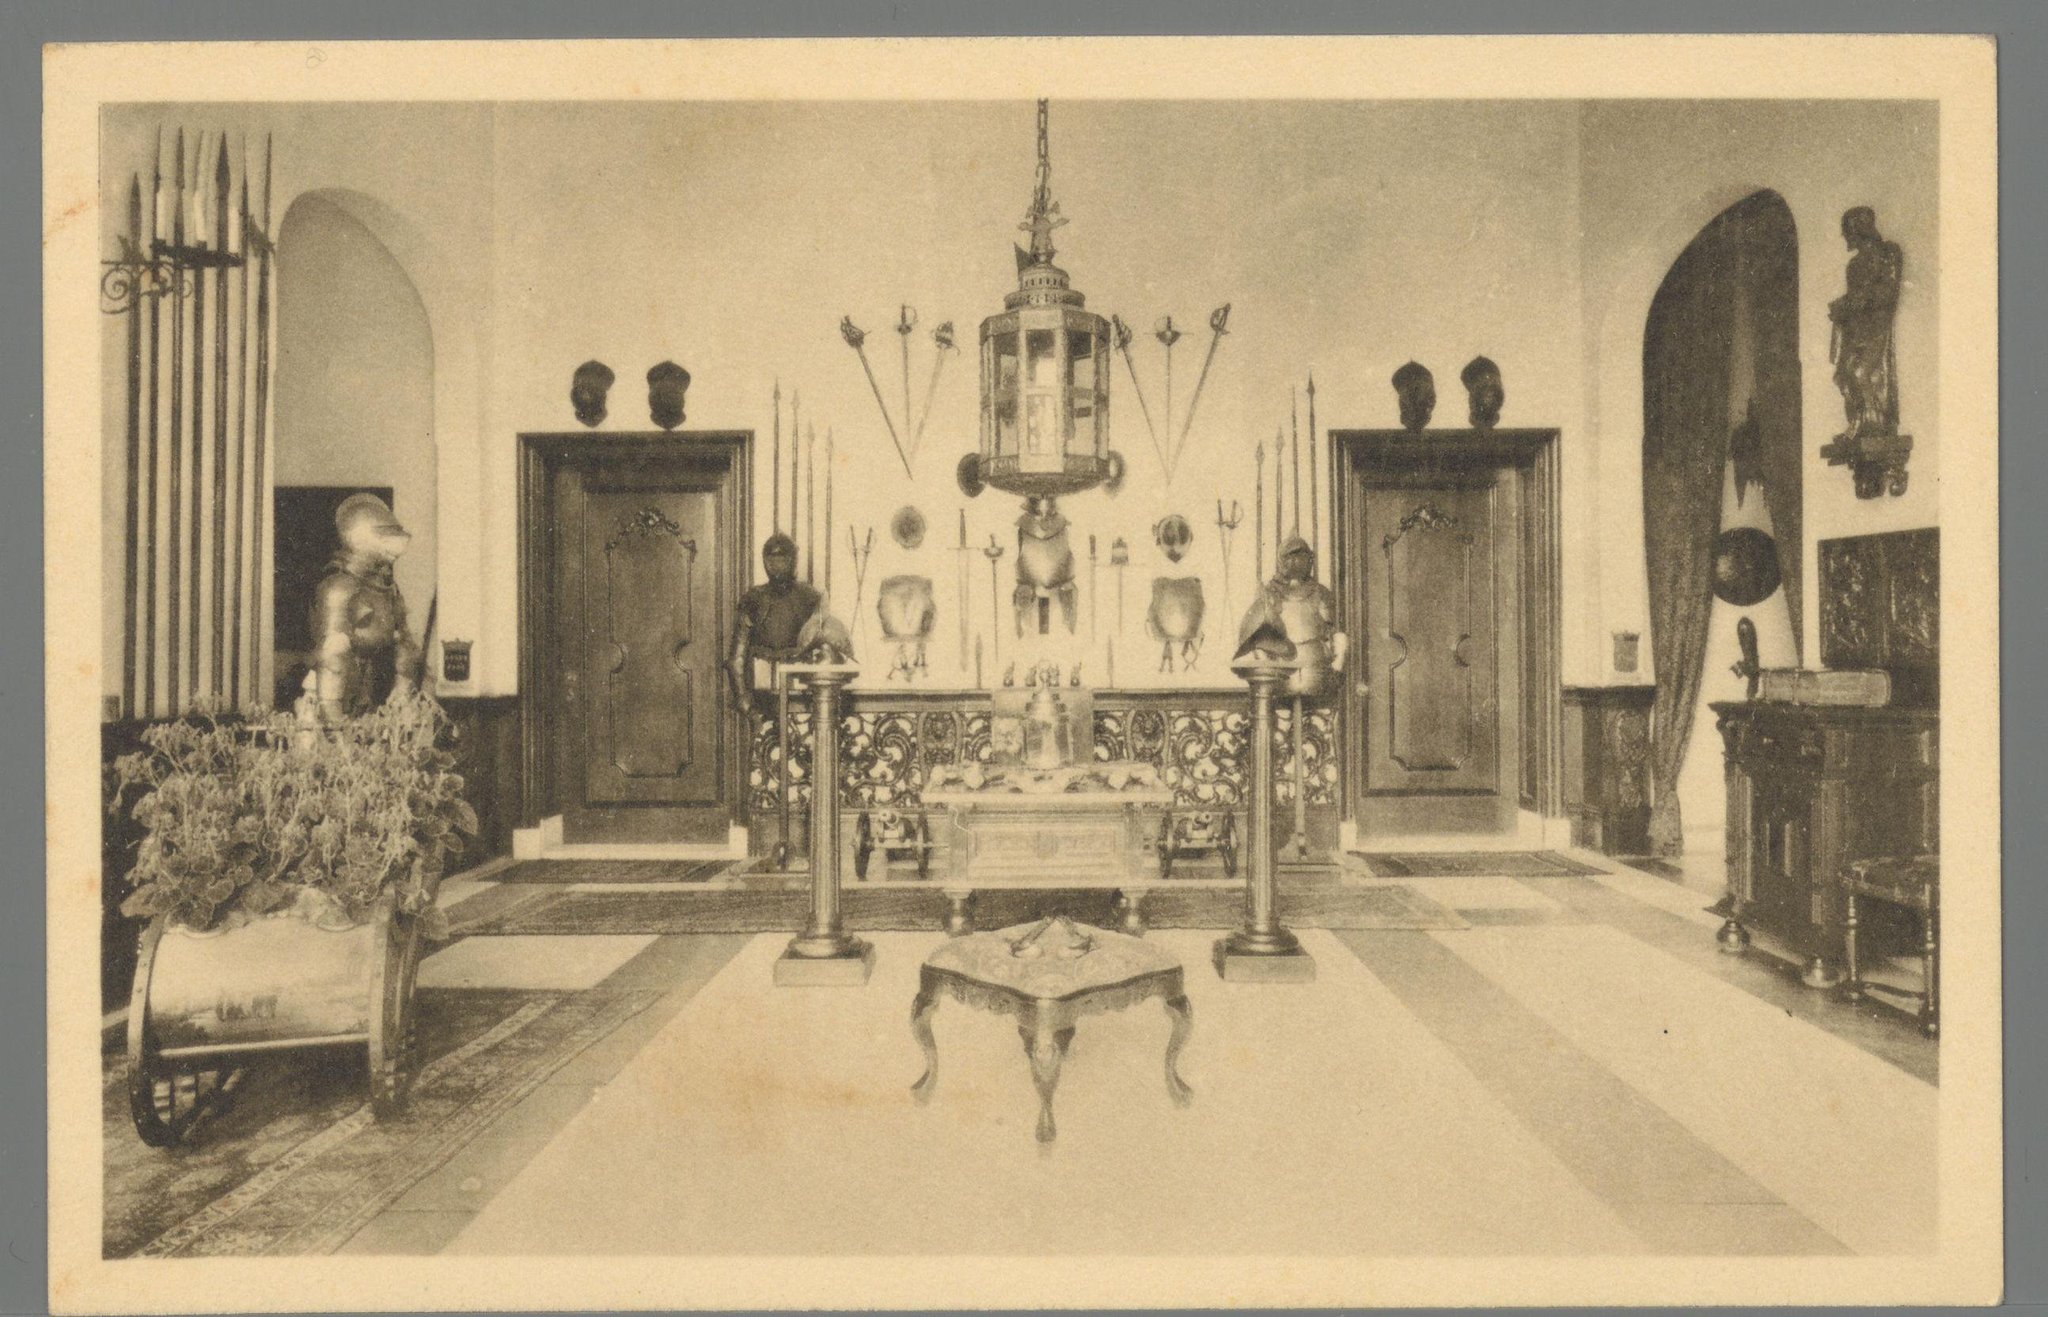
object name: ansichtkaart, prentbriefkaart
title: De Zonheuvel: Hal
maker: Anonymous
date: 1913-1950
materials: cardboard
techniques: photograph, writing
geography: doorn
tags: vestibule, hall, villa